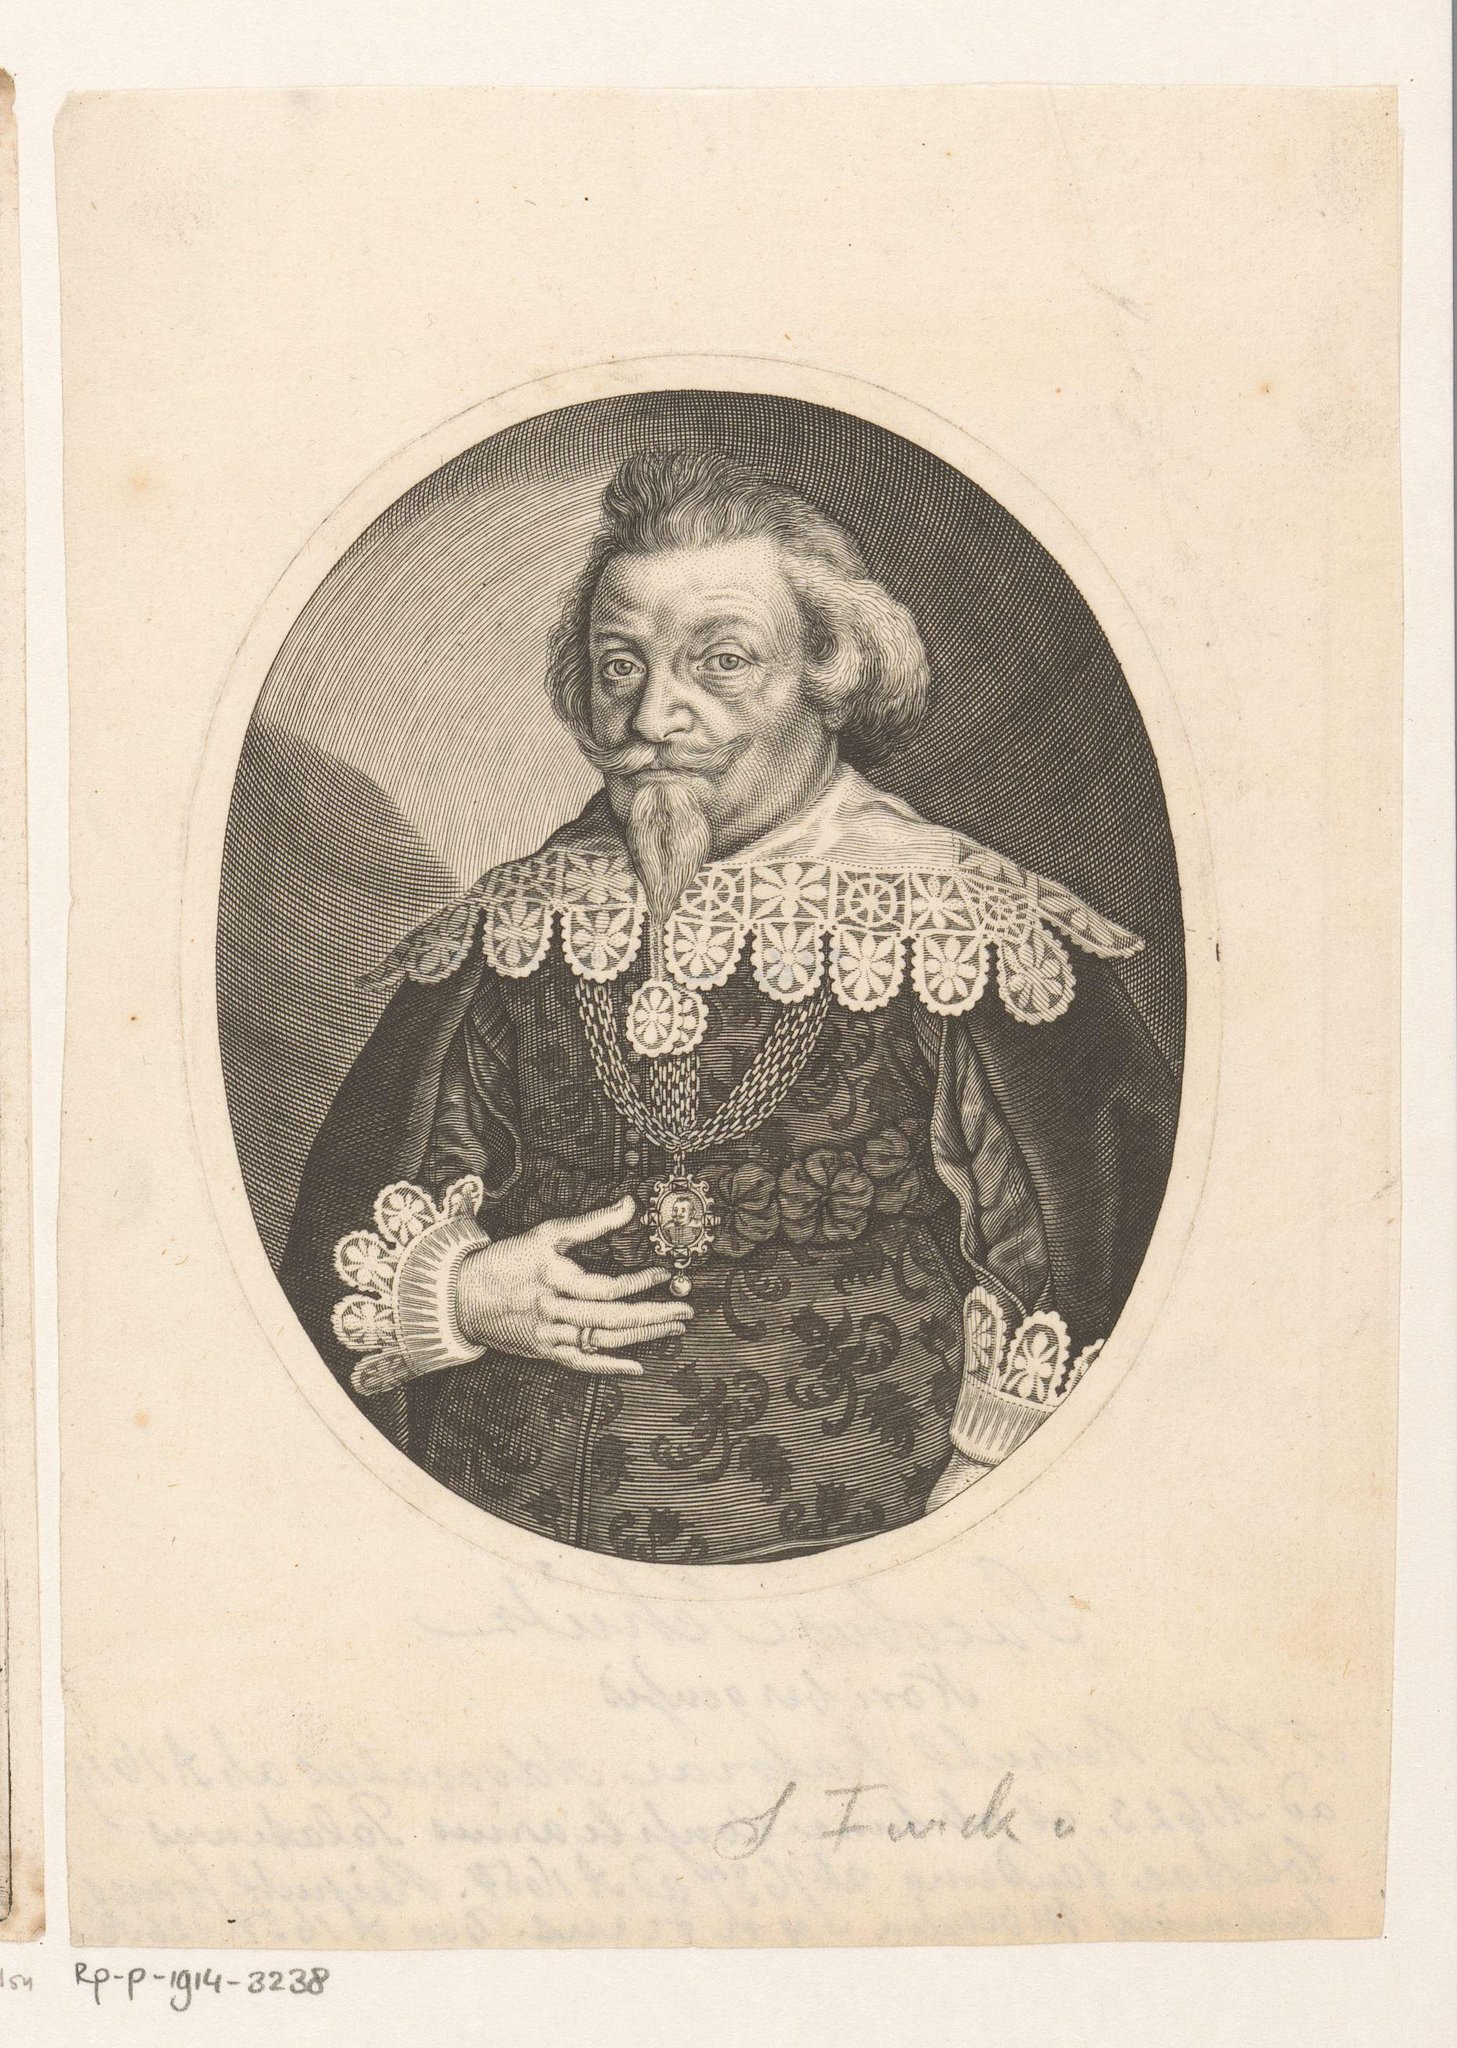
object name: print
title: Portret van Jacob Schütz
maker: sebastian furck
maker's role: print maker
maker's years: 1600-1655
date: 1610-1654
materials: paper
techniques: engraving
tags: historical persons, meditation over skull and/or crucifix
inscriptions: collector's mark: Lugt 2228